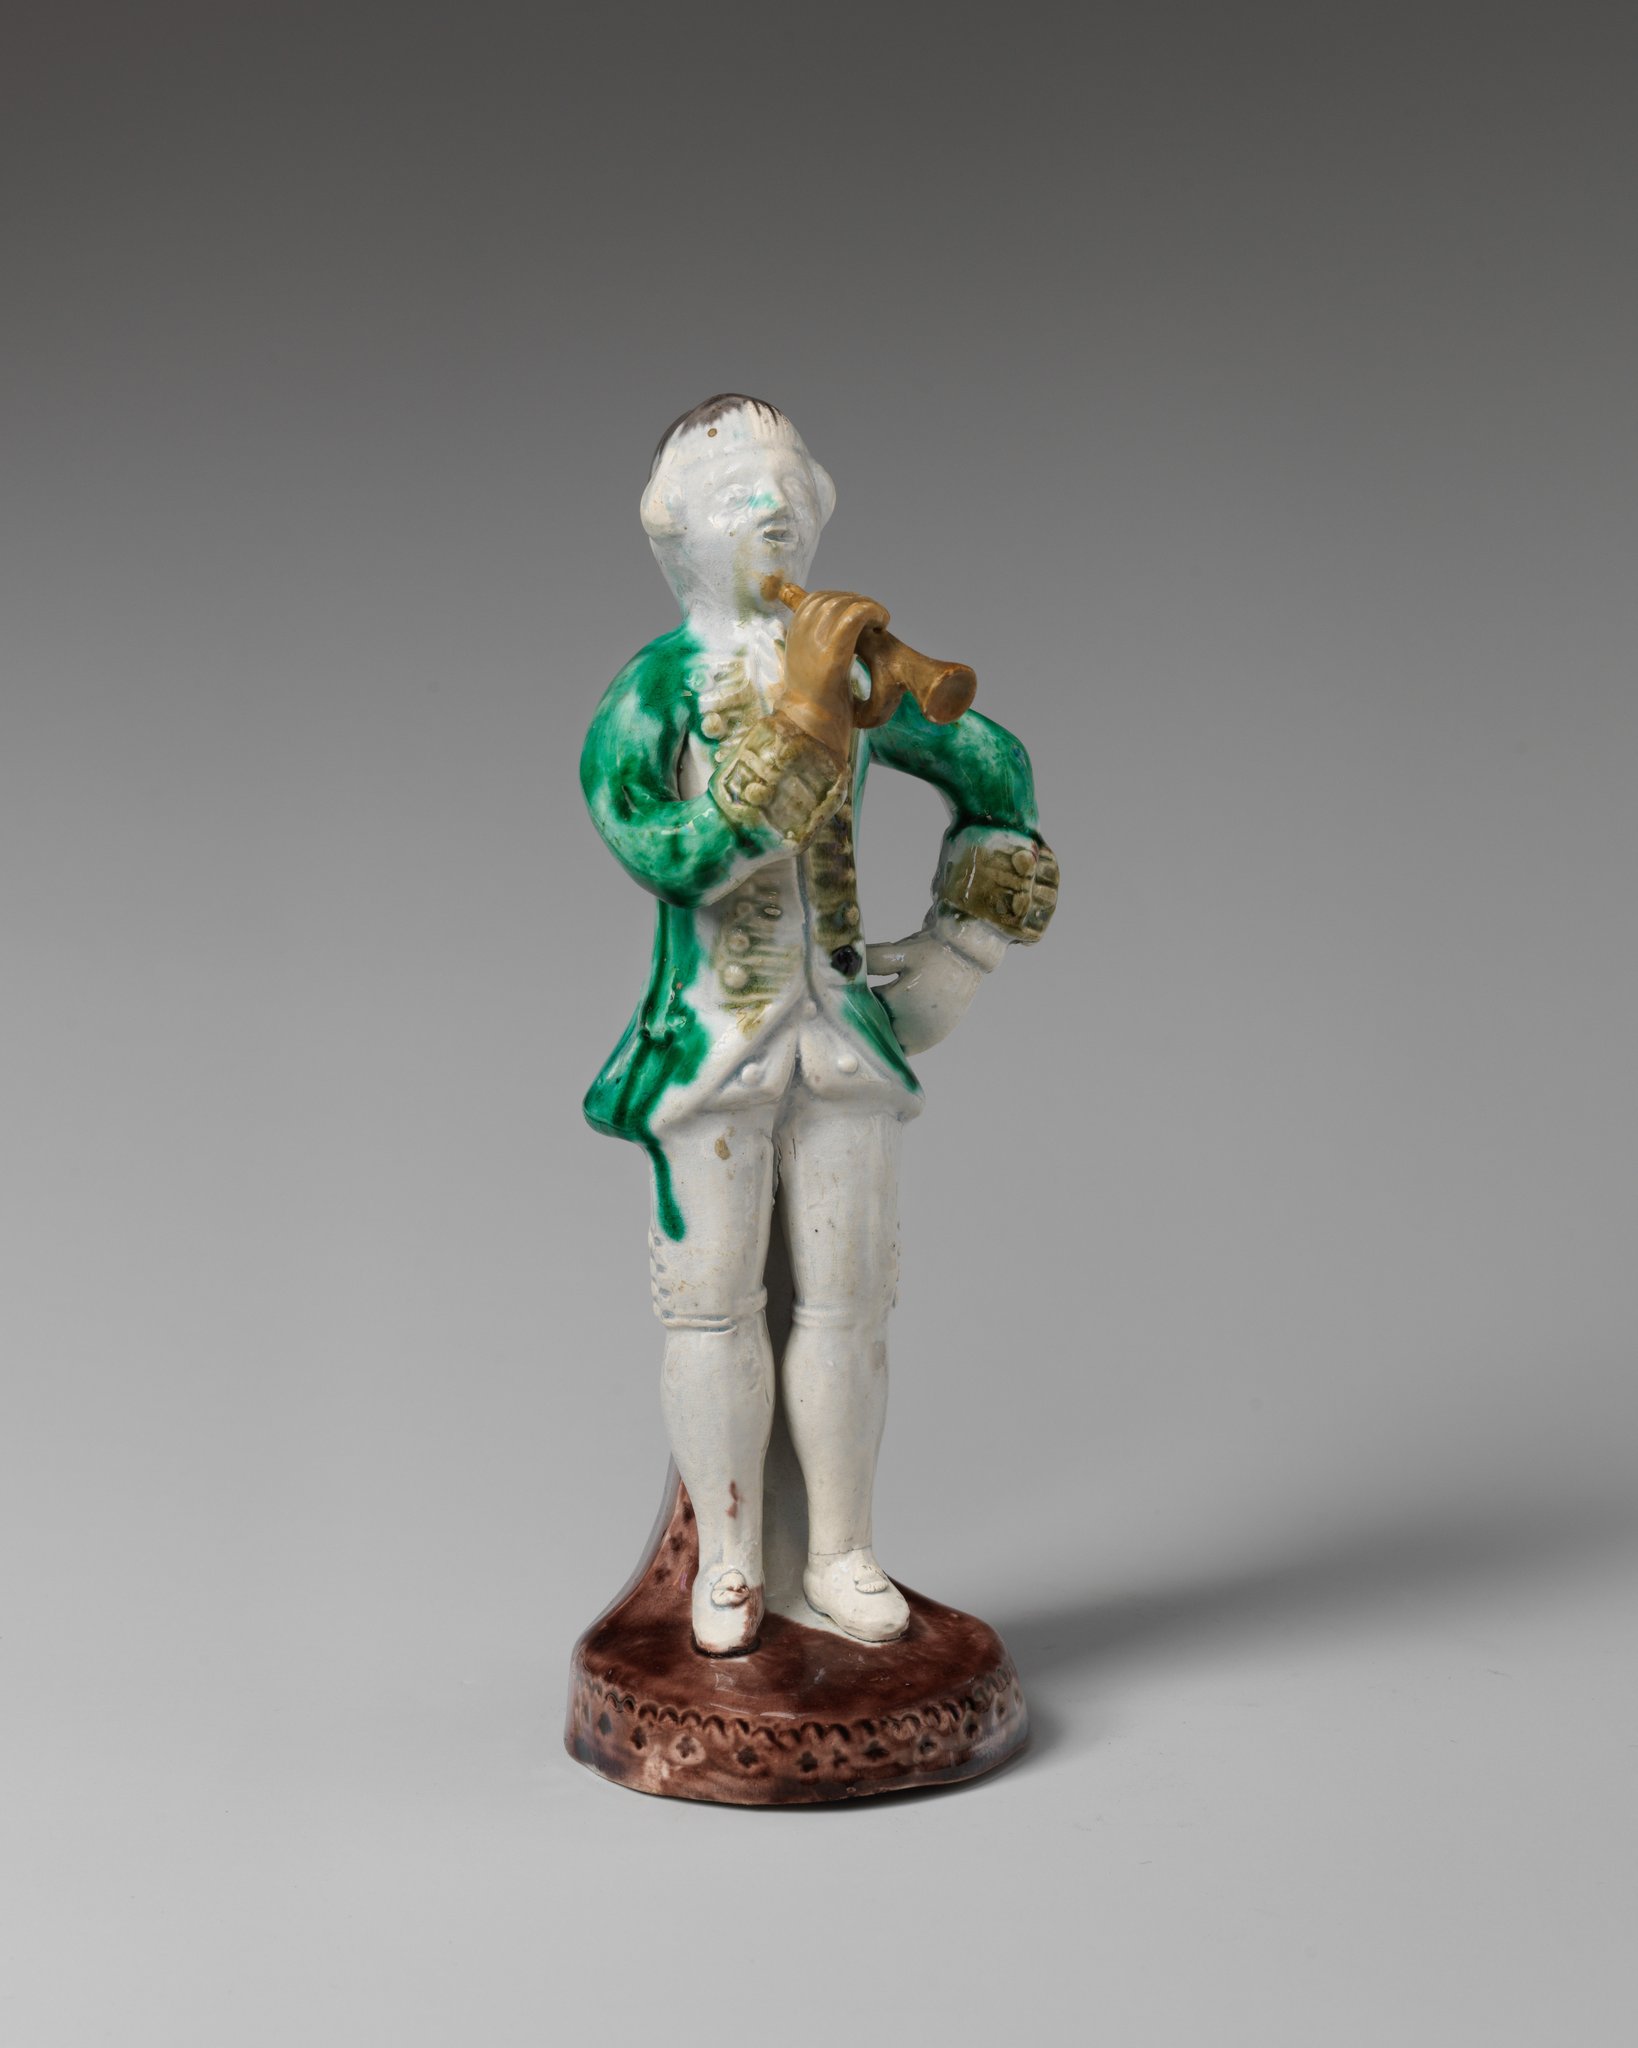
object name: figure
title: Bugler in military dress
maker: astbury-whieldon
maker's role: maker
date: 1750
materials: earthenware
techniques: glazing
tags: musical instruments,men,musicians